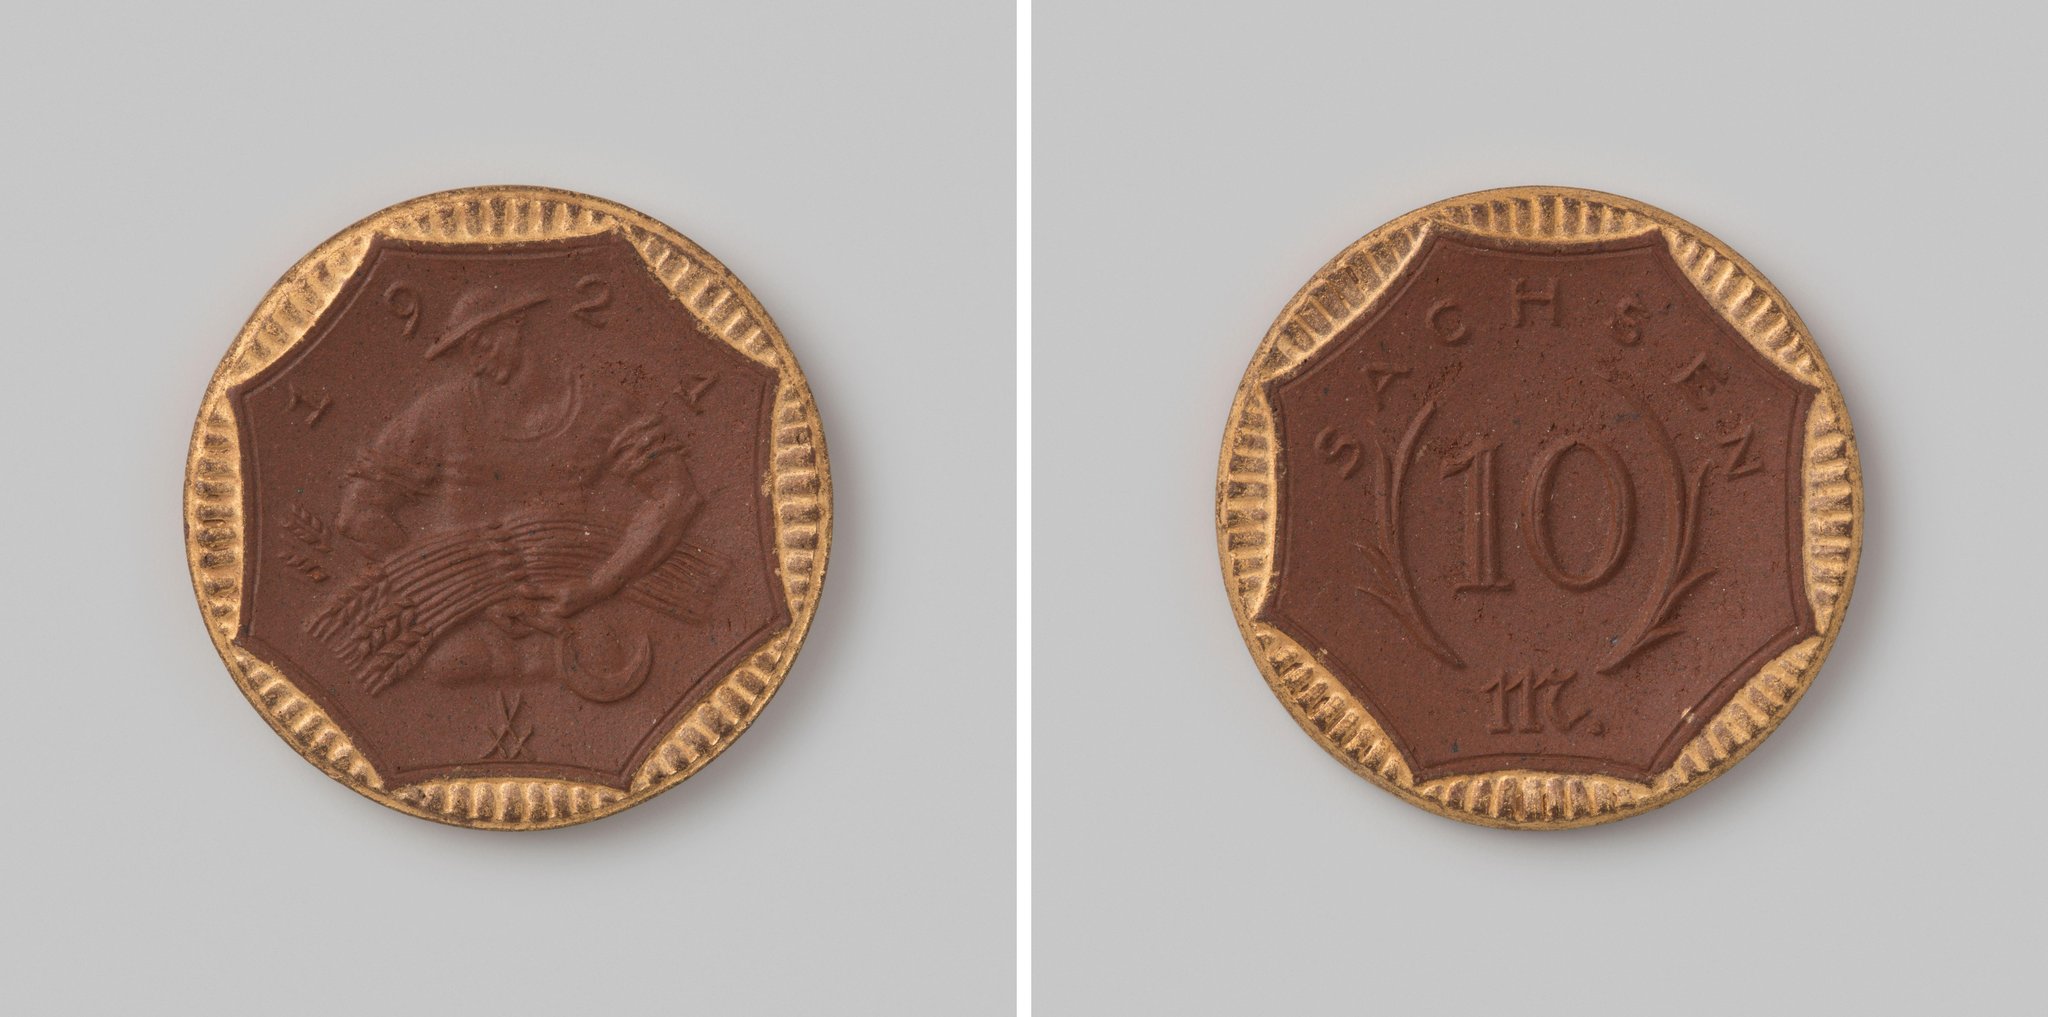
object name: coin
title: 10 mark uit Duitsland, Saksen, 1921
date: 1921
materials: porcelain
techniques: casting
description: Porseleinen pseudomunt met vergulde rand. Voorzijde: boer ten halve lijve met sikkel en aren, waarboven jaartal. Keerzijde: binnen versiering waarde-aanduiding in twee regels. Daaromheen land-aanduiding. Gladde rand.